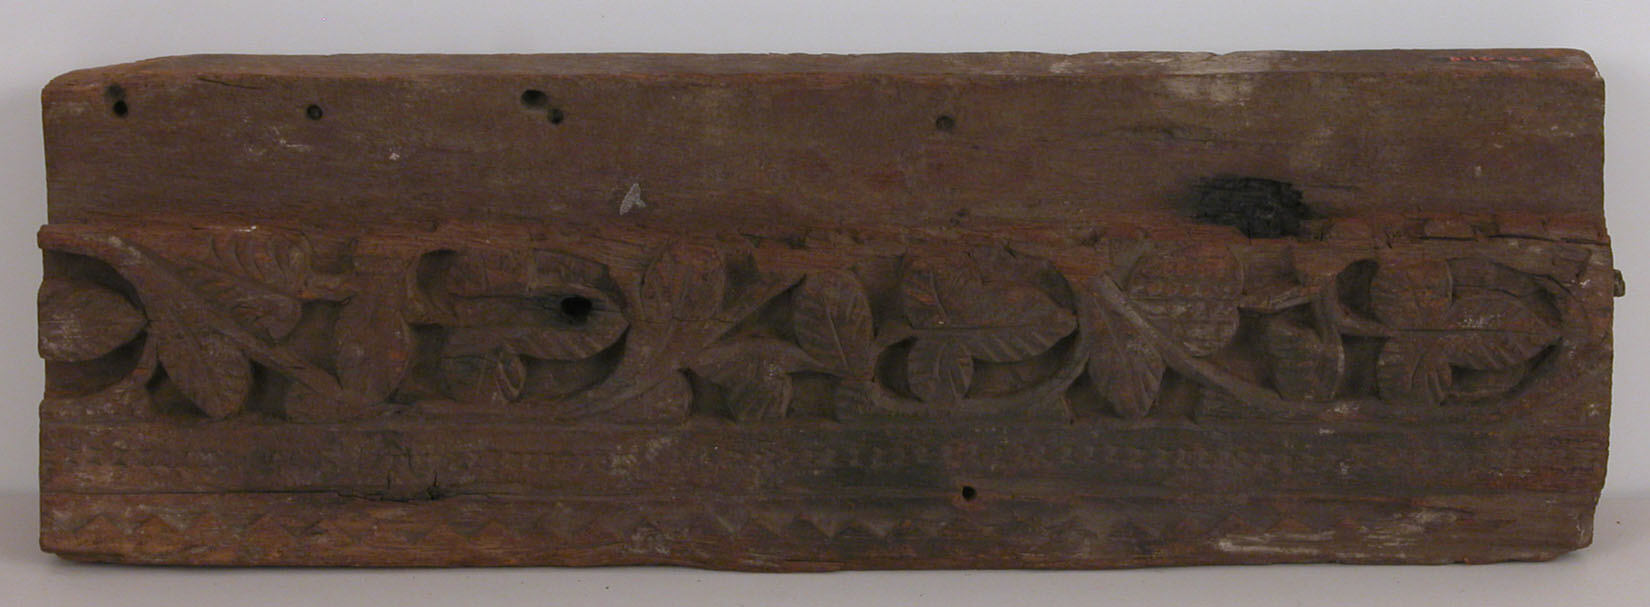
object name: panel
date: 701-900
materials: wood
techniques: carving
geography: iraq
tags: leaves